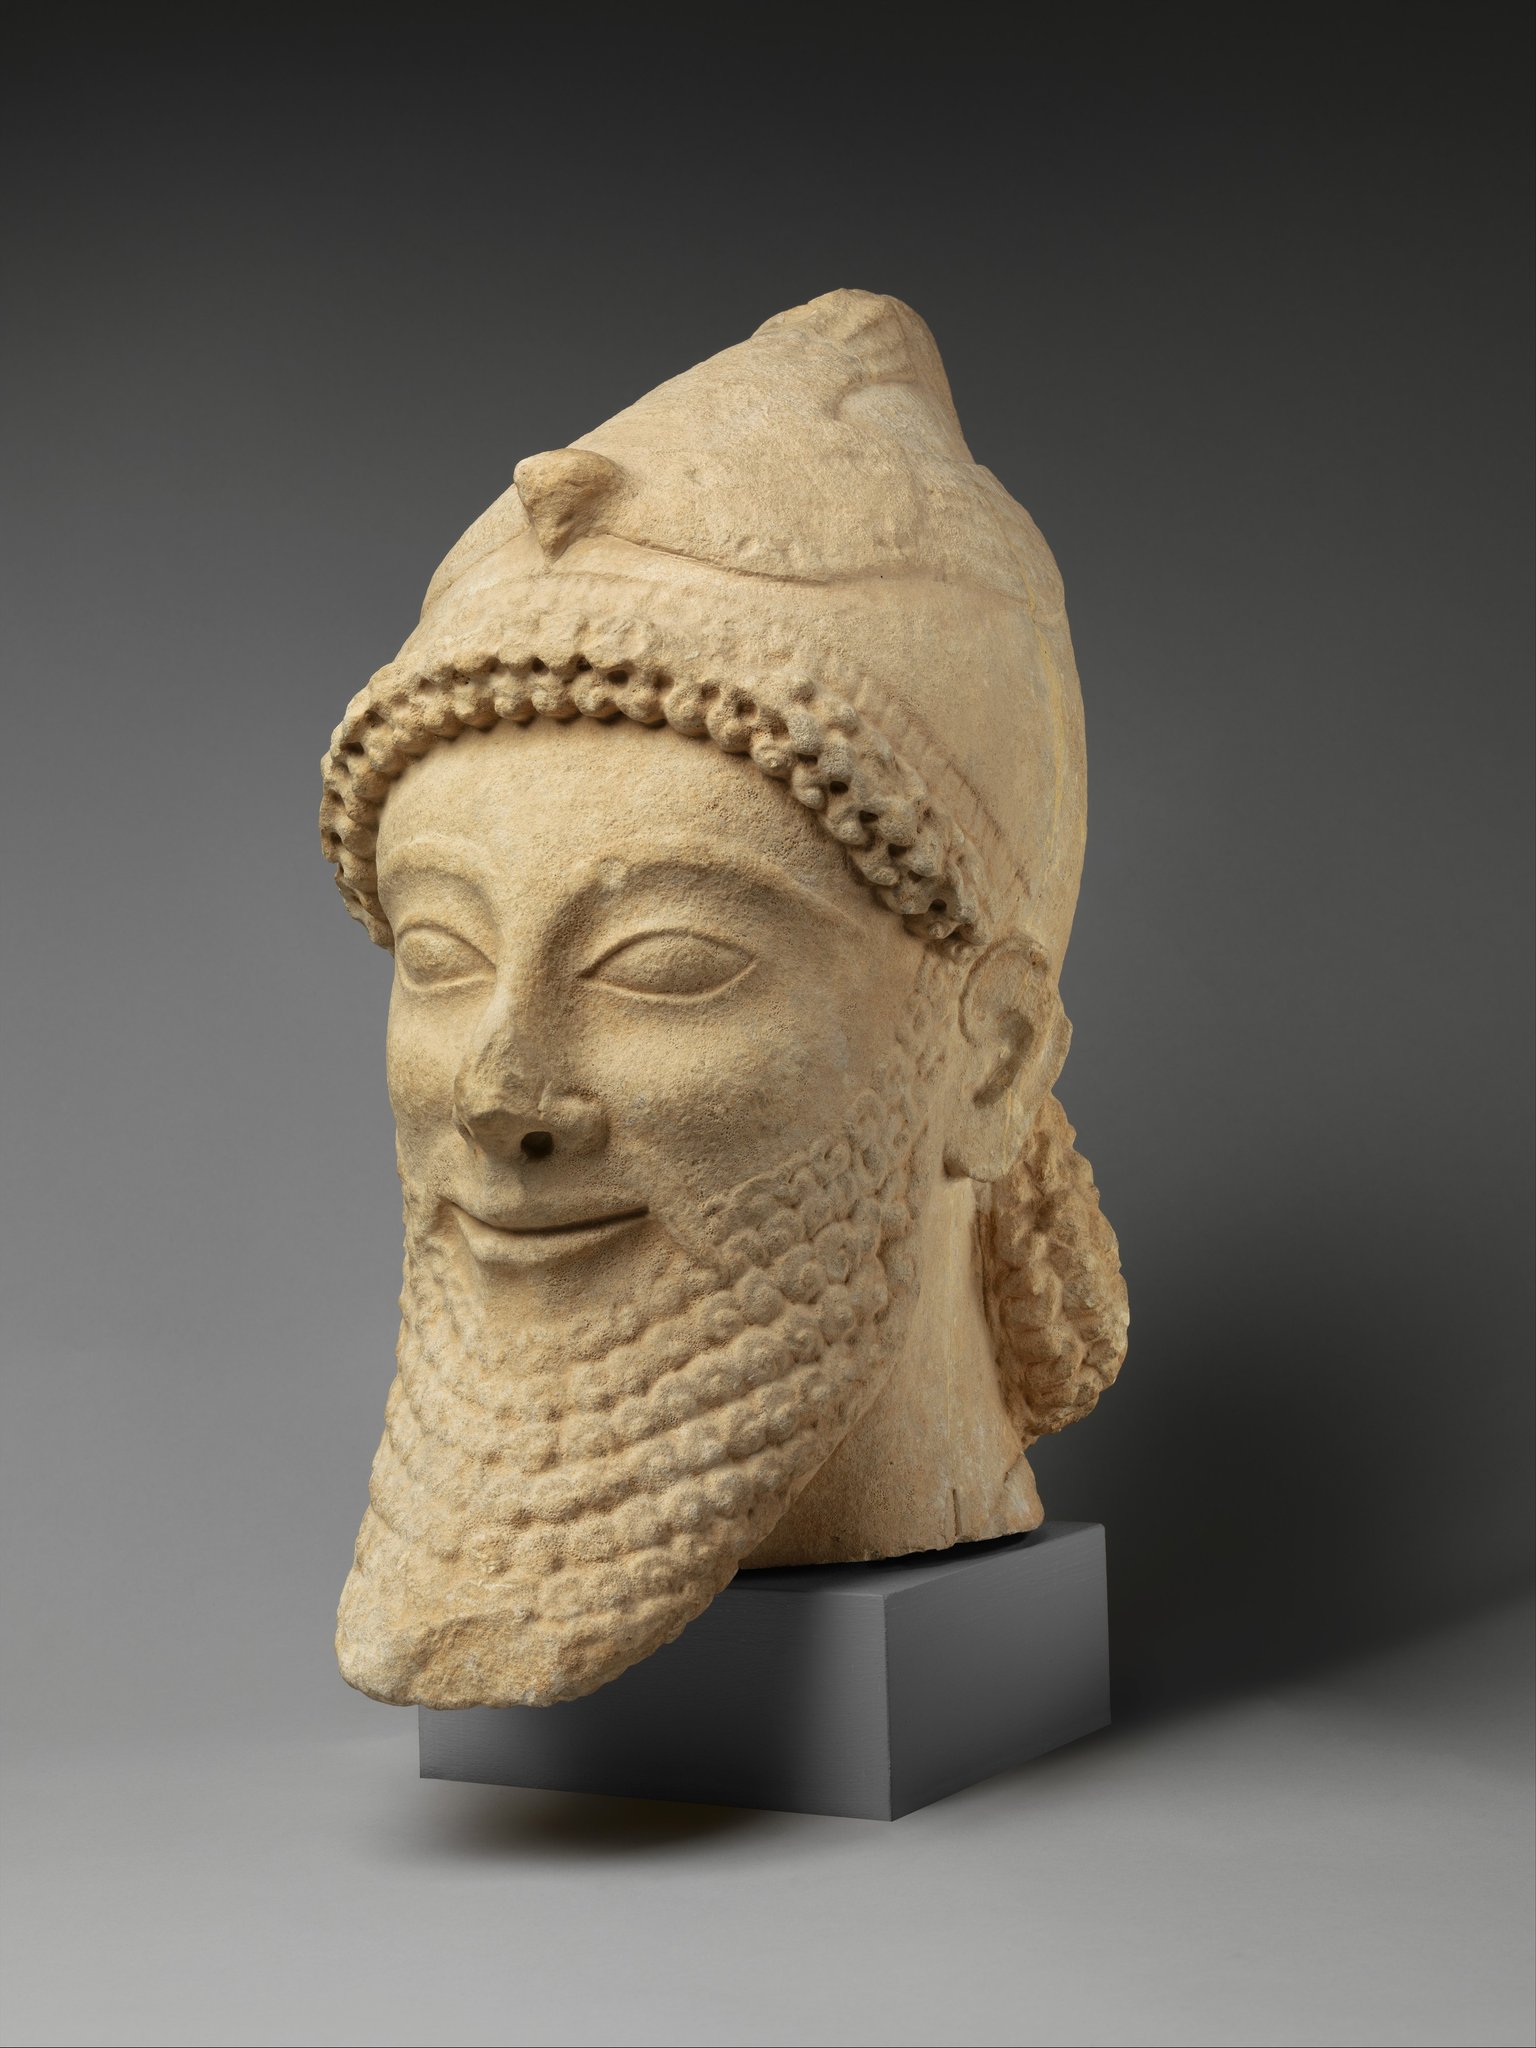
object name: head of a man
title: Limestone male head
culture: cypriot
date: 525-501 BCE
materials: limestone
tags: birds,heads,men